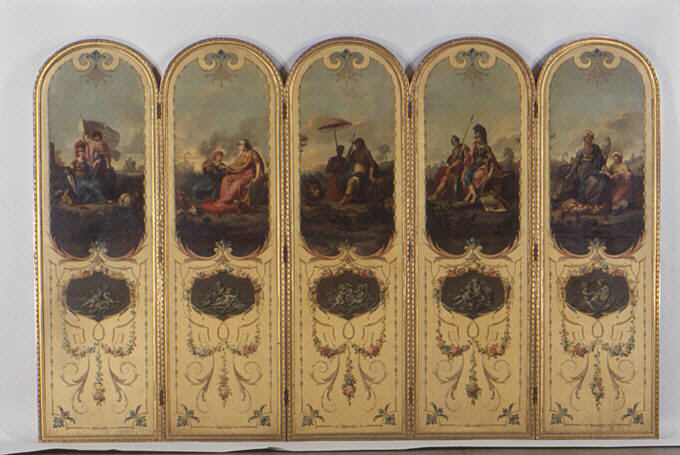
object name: screen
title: Five-fold screen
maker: jean jacques françois le barbier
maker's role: designer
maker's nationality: french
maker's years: 1738-1826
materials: canvas, gilt, oil, panel, silk, wood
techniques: lining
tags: men,women,cupid